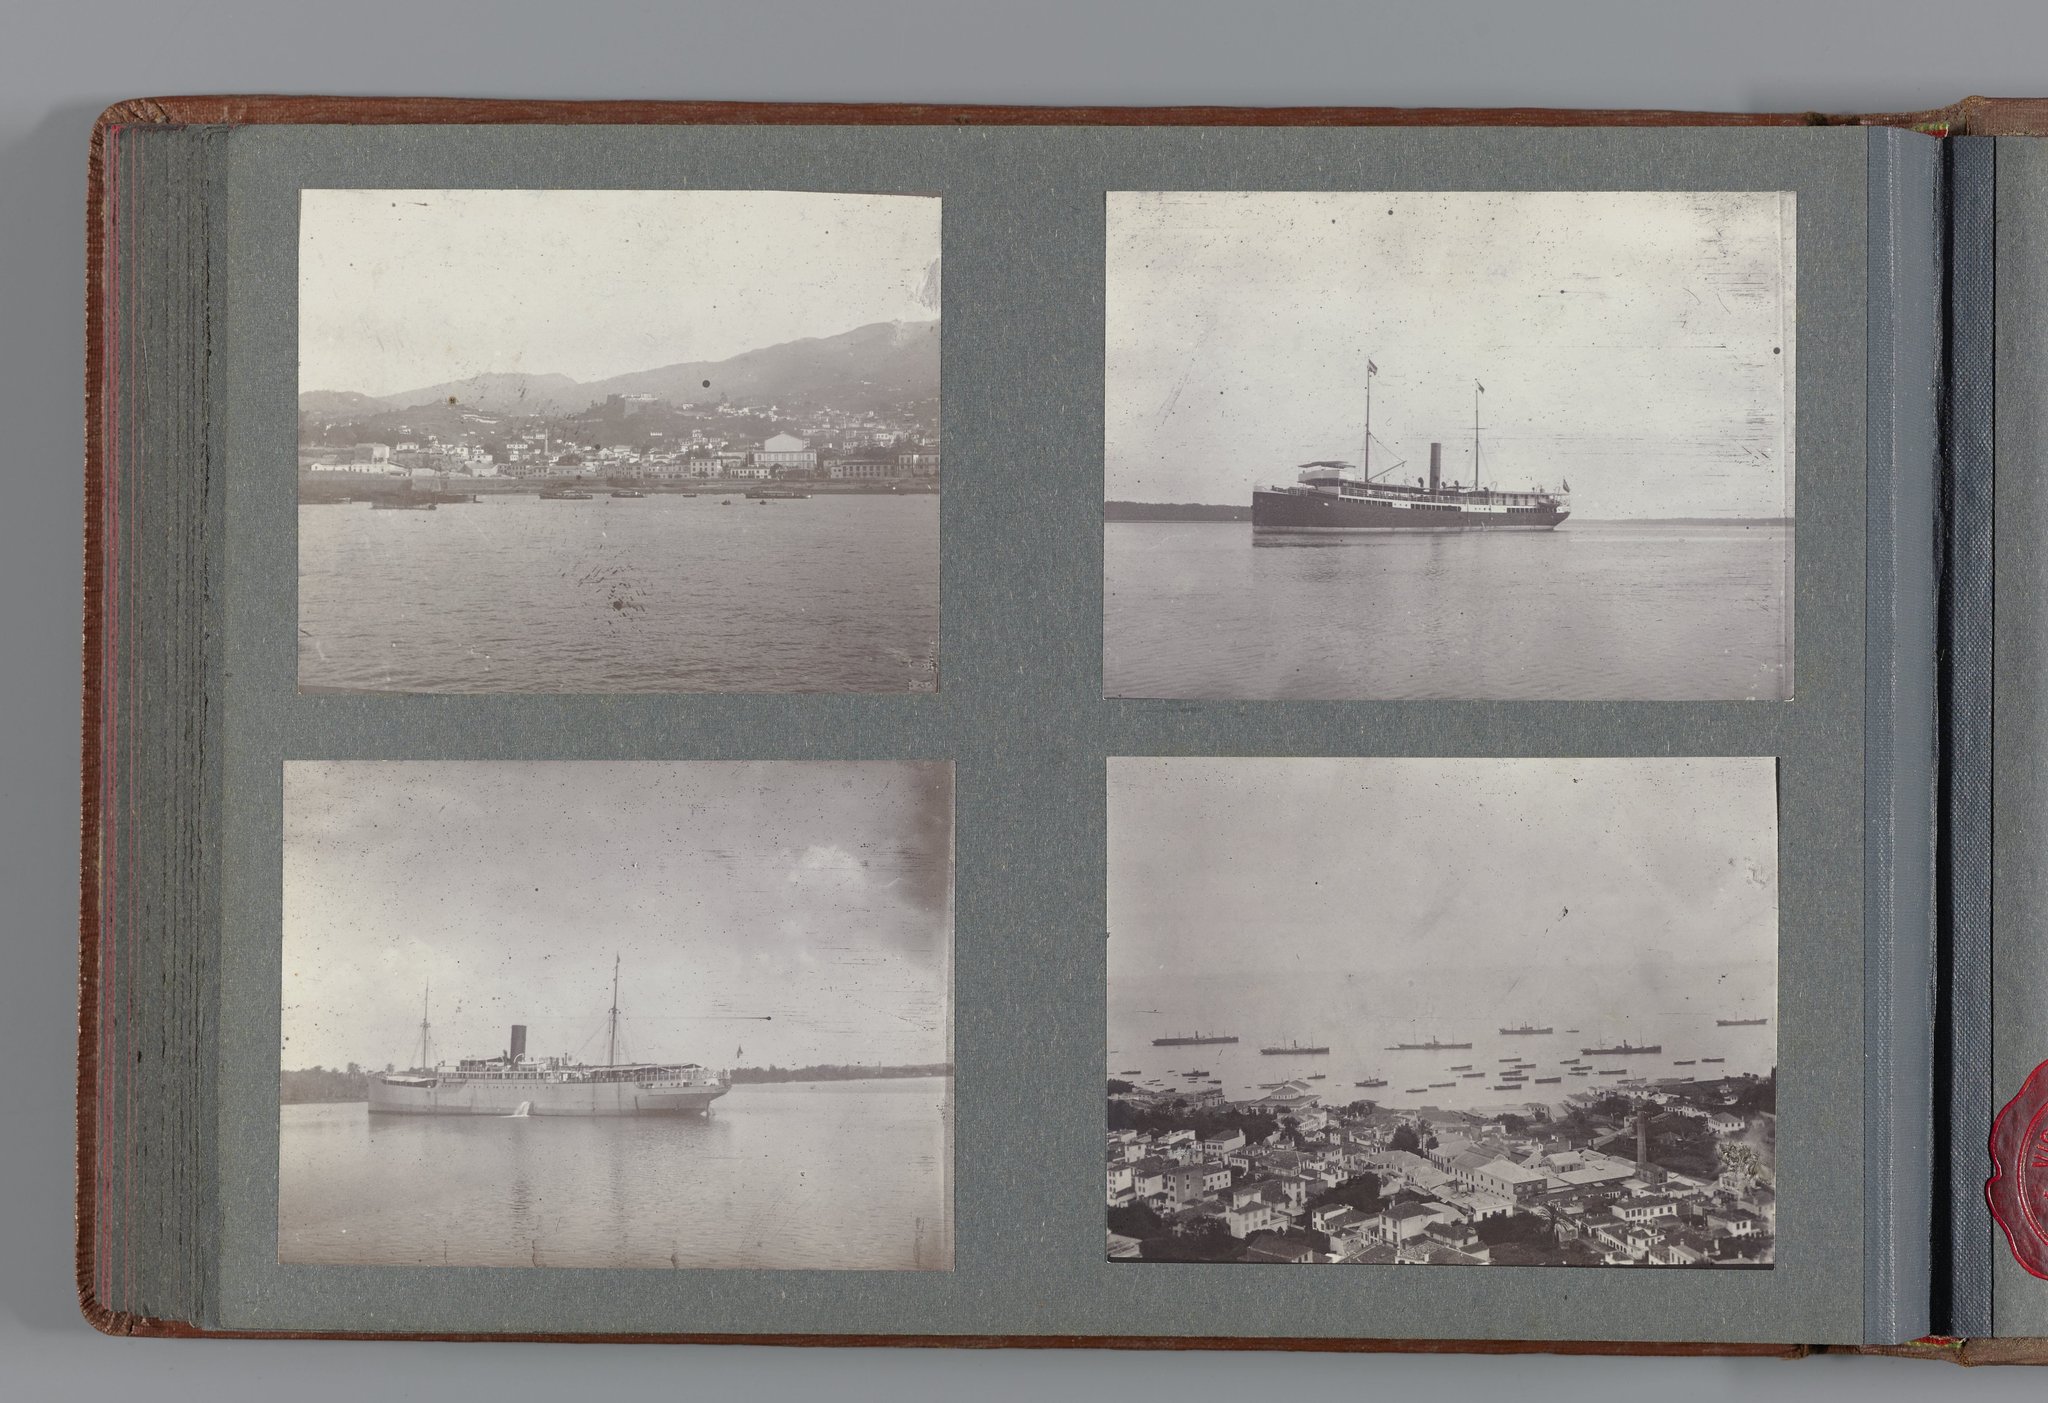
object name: photograph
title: Kustlijn van Paramaribo gezien vanaf het water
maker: Anonymous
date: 1905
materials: cardboard, paper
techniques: photography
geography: paramaribo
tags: paramaribo (stad)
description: Kustlijn van Paramaribo gezien vanaf het water. Onderdeel van fotoalbum 'Suriname'.